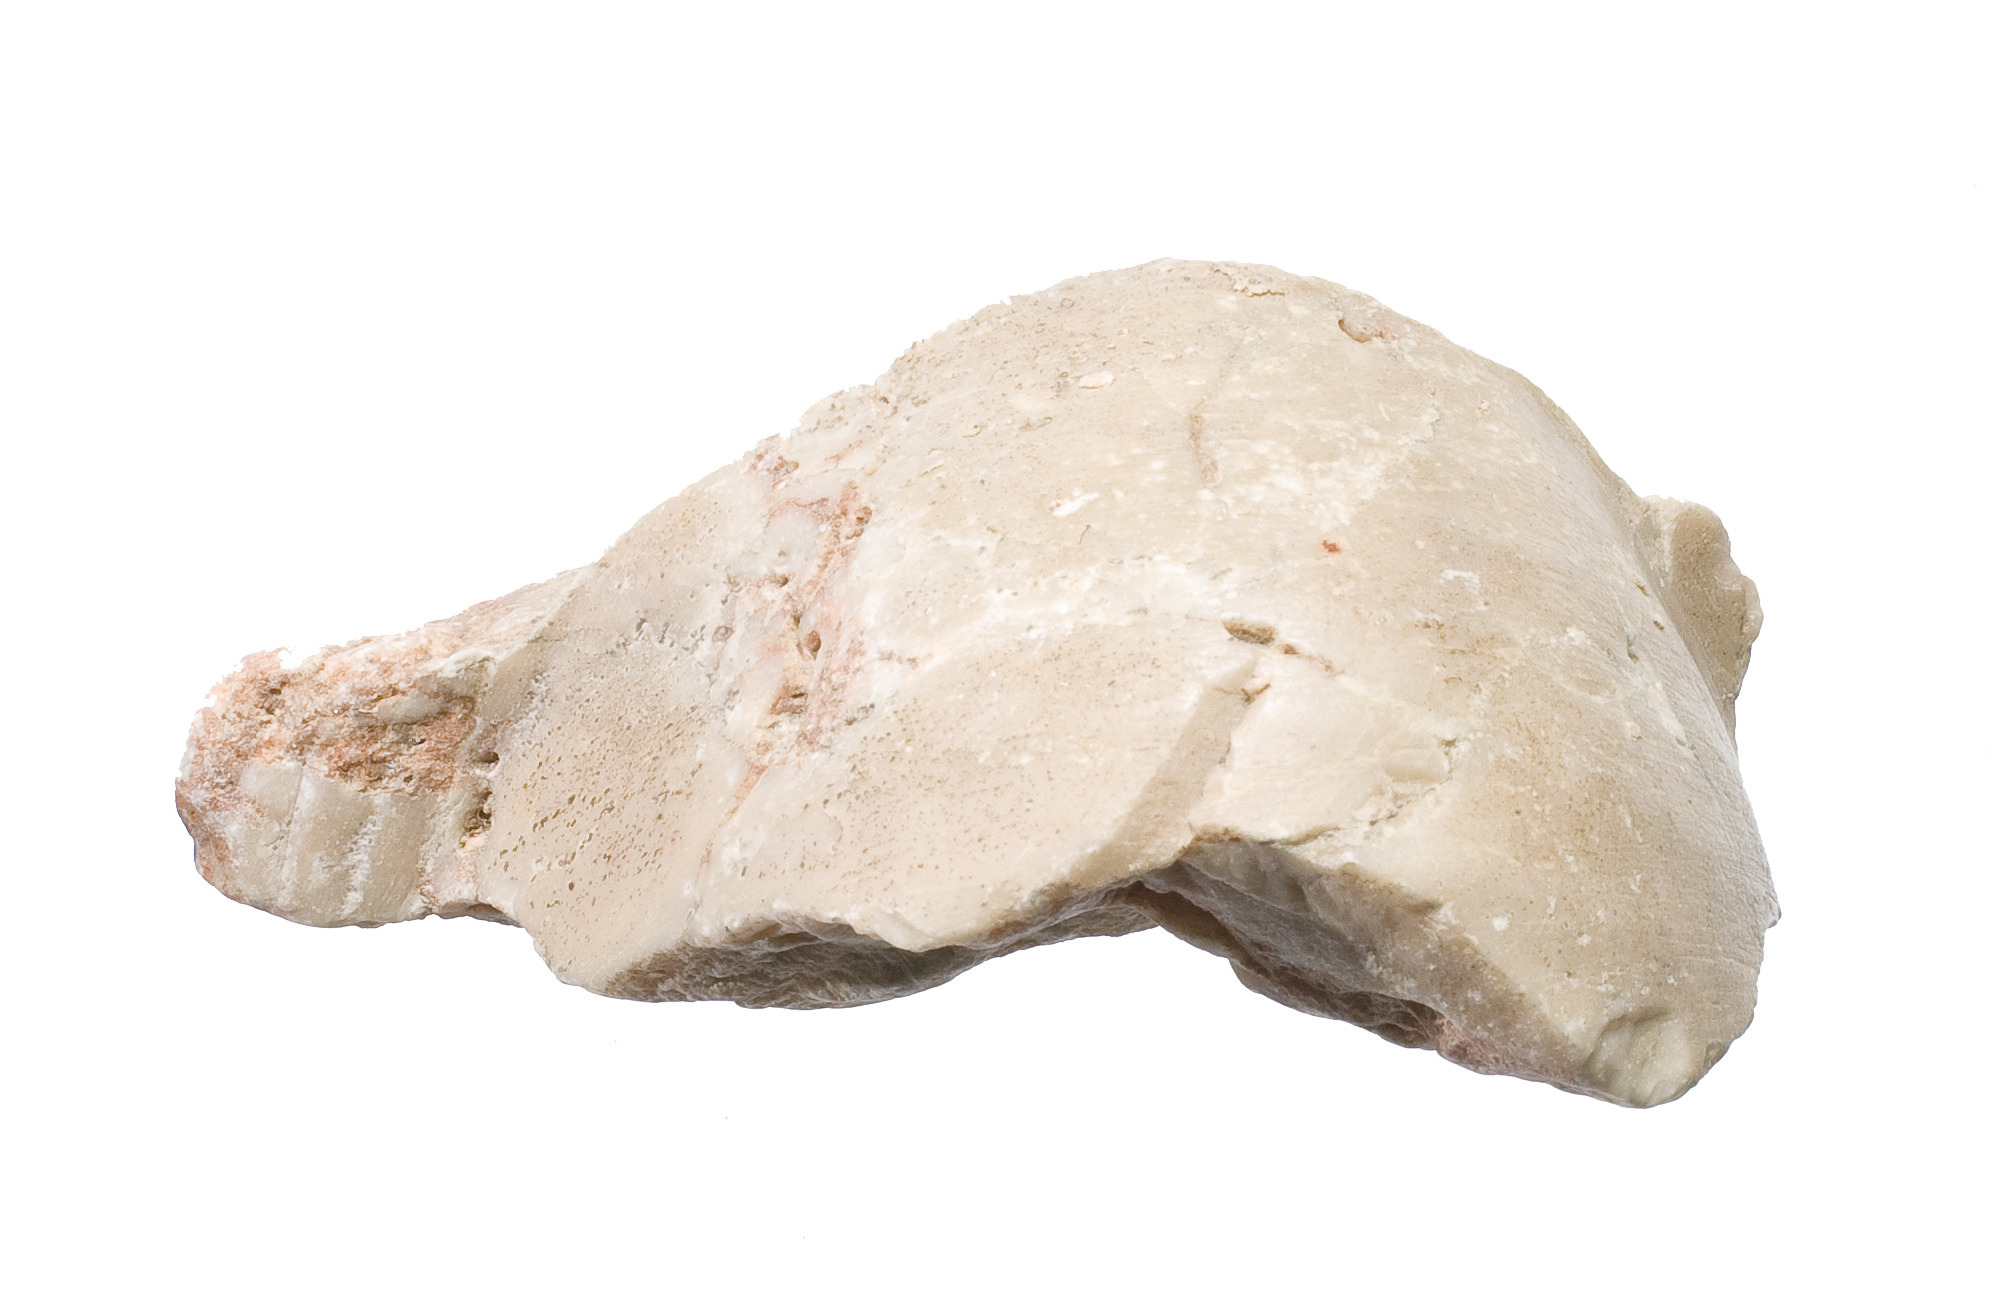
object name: shoulder with garment and wig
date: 1353-1336 BCE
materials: limestone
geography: egypt